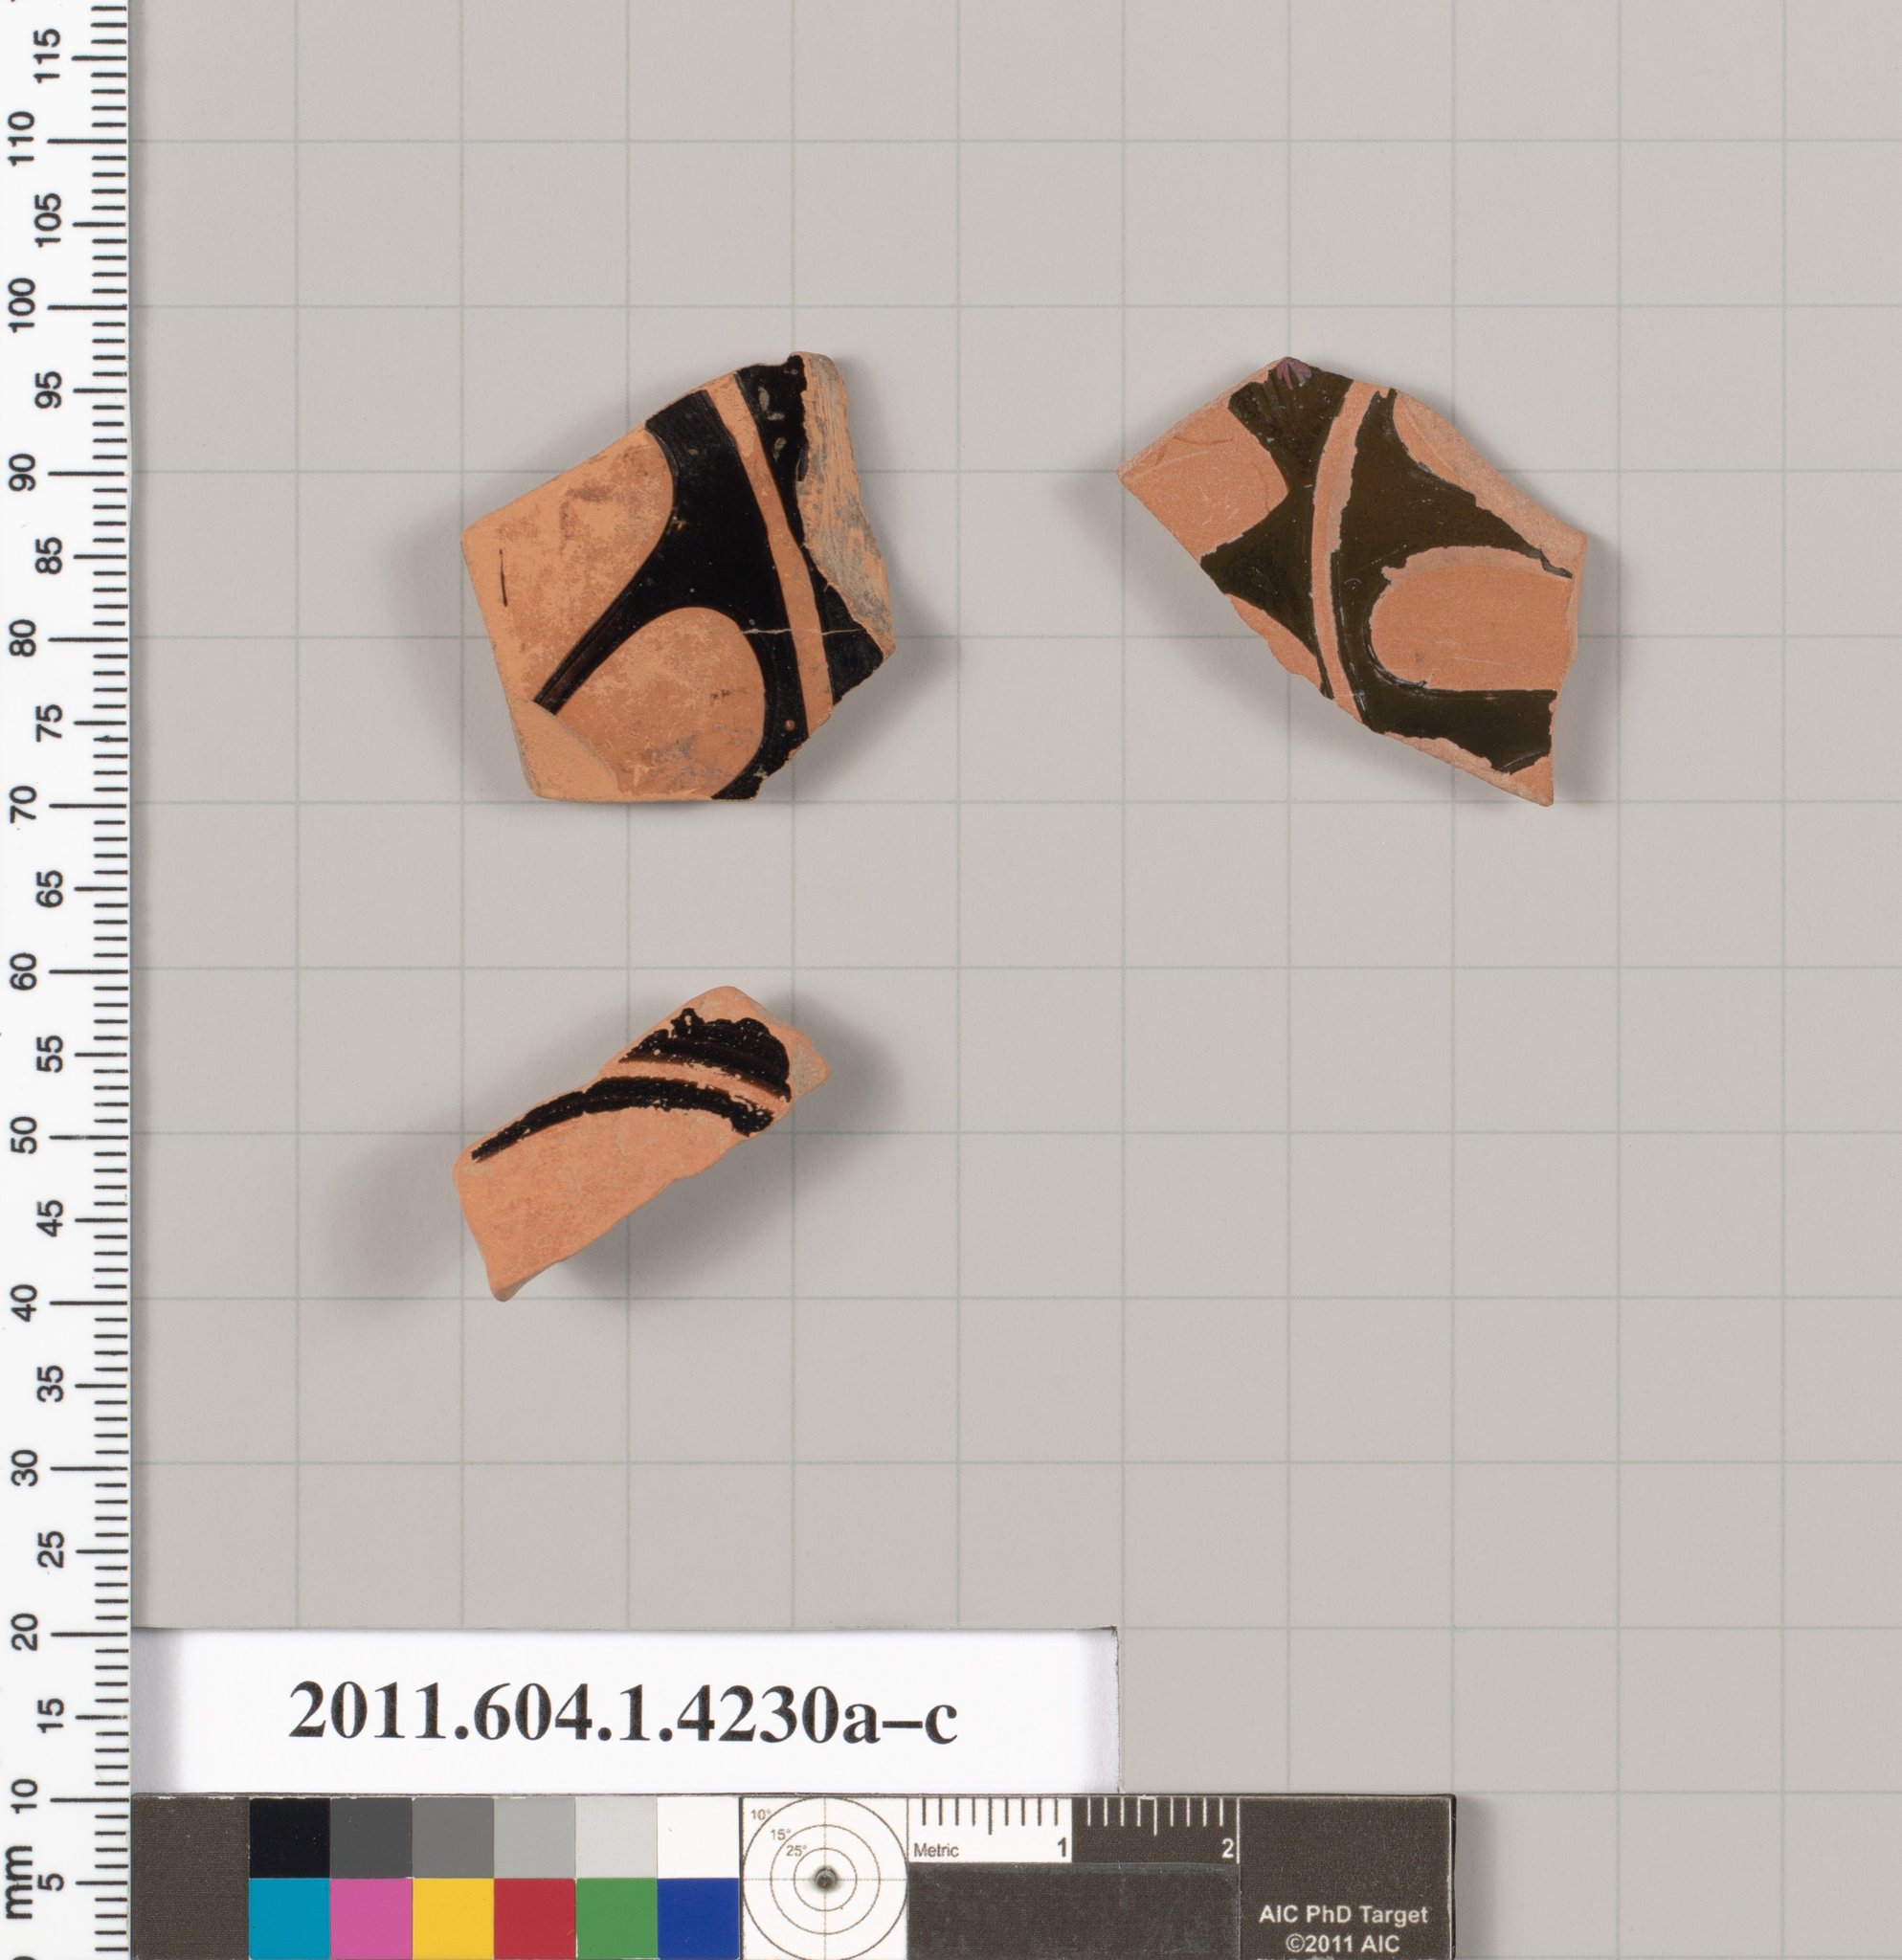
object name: kylix fragment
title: Terracotta fragments of kylikes (drinking cups)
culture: greek, attic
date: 520-500 BCE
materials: terracotta